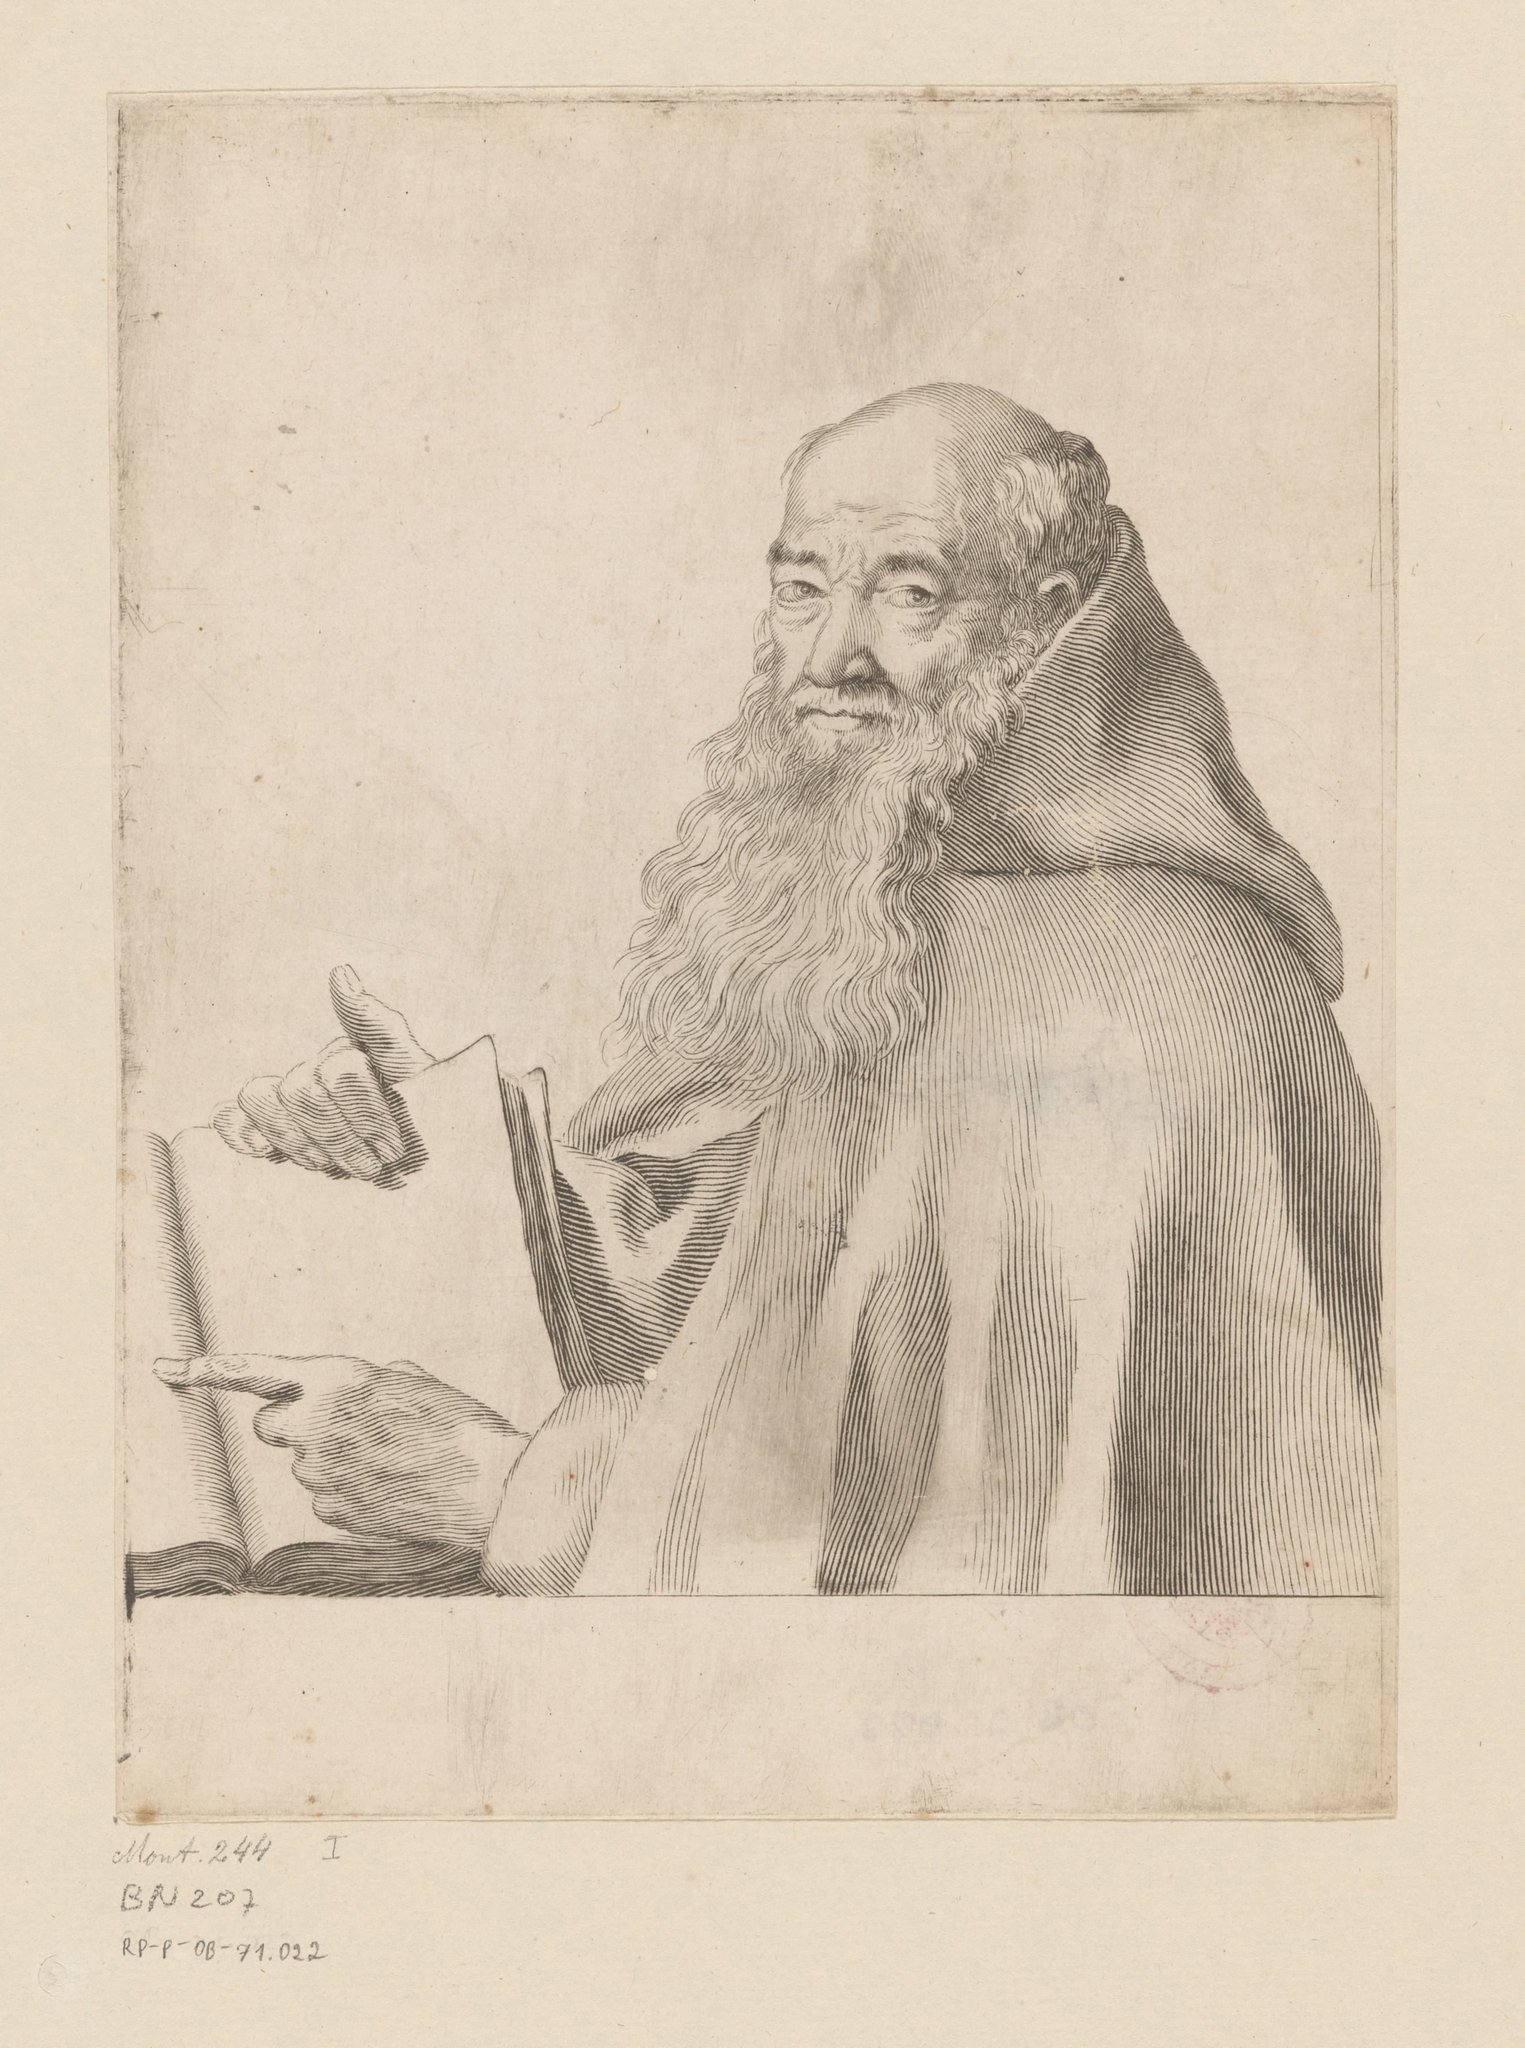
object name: print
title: Portret van Père Yves op 87-jarige leeftijd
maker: claude mellan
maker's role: draughtsman, print maker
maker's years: 1598-1688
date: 1677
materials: paper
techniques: engraving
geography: france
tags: historical persons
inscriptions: collector's mark: Lugt 2228